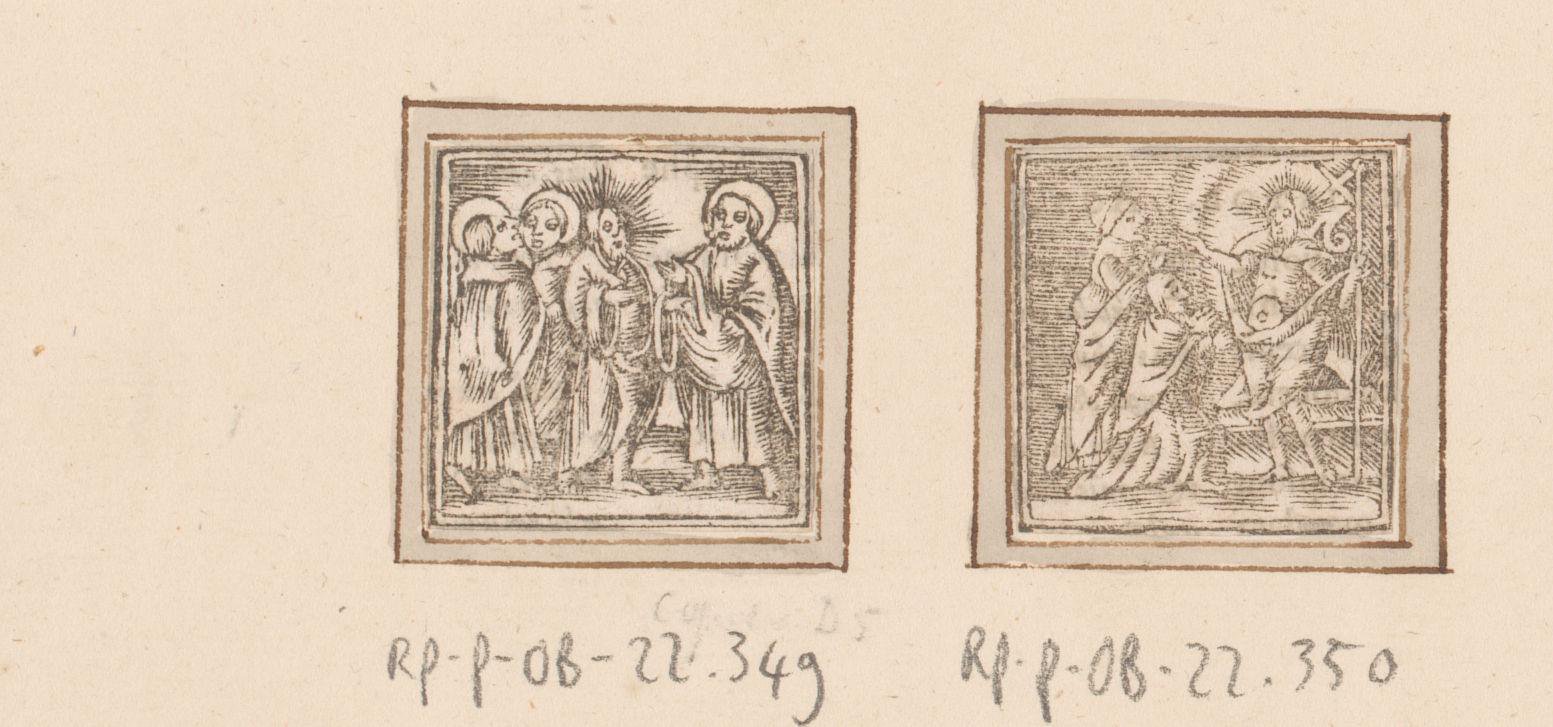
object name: print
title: Bijbelillustraties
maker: Anonymous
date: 1590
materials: paper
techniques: woodcut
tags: christ preaching or teaching (in general)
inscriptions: collector's mark: Lugt 240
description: Prent afkomstig uit een onbekende Latijnse bijbel, mogelijk gedateerd 1590.